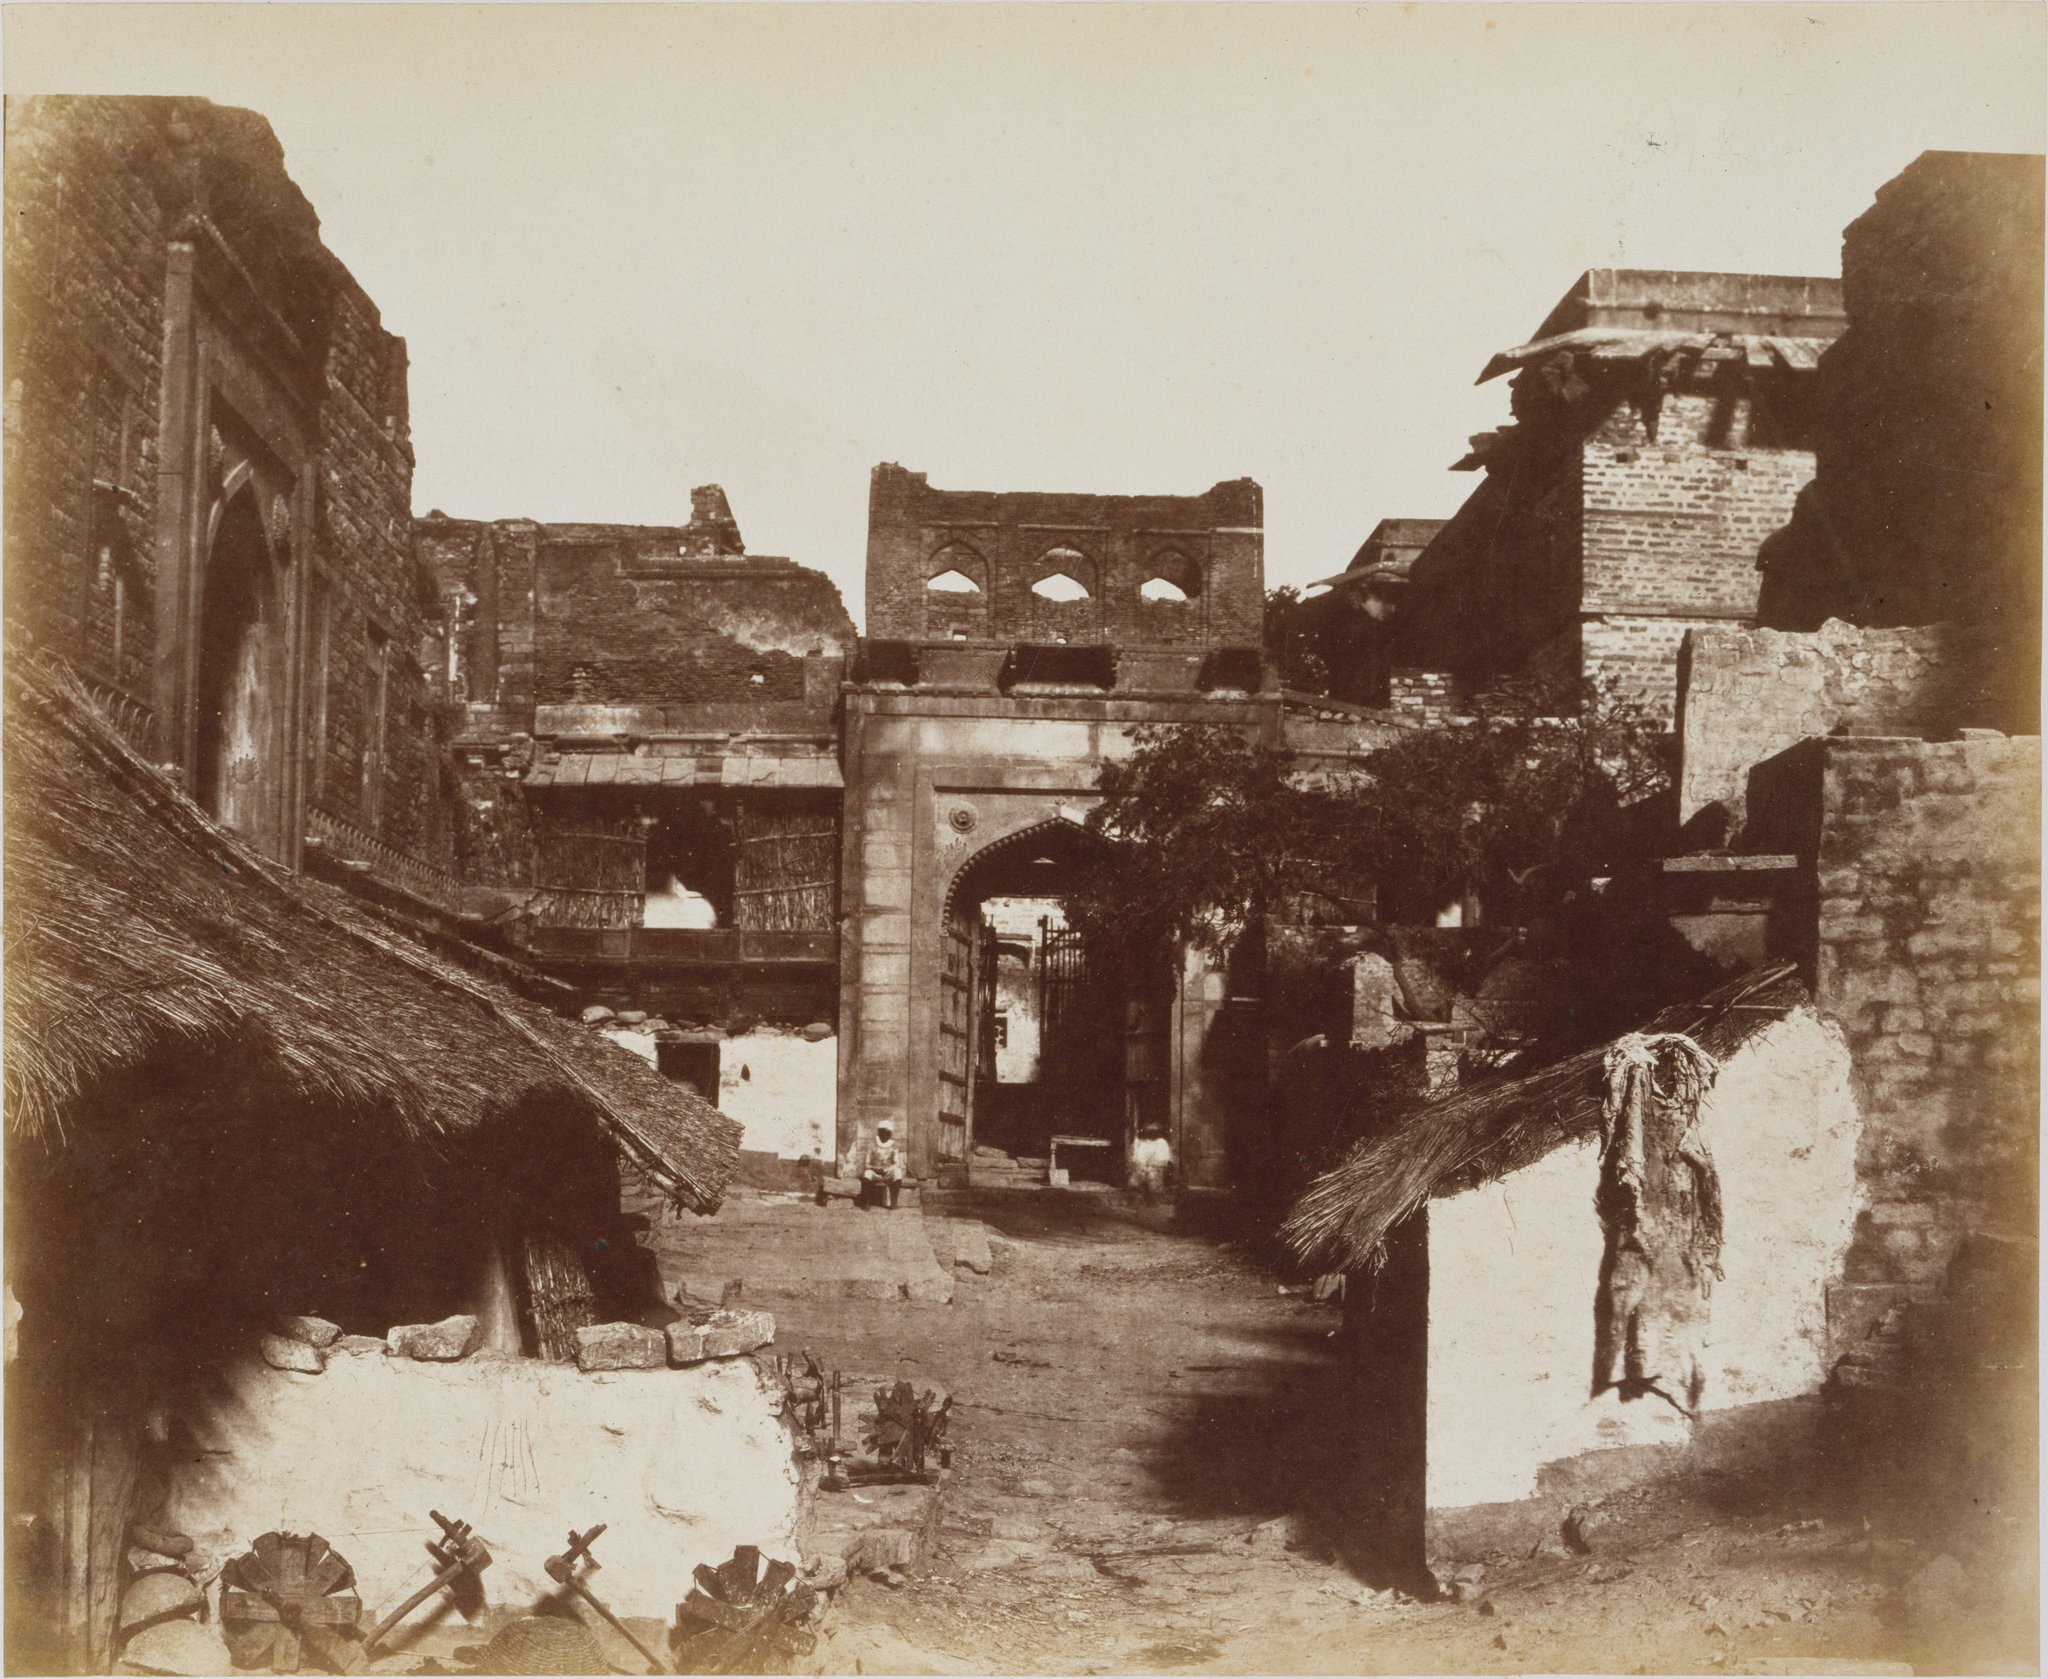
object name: photograph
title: Street in Fatehpur Sikri, India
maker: john murray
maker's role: artist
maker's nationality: british, scottish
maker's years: 1809-1898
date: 1858-1862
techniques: albumen silver print, paper negative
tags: architecture,buildings